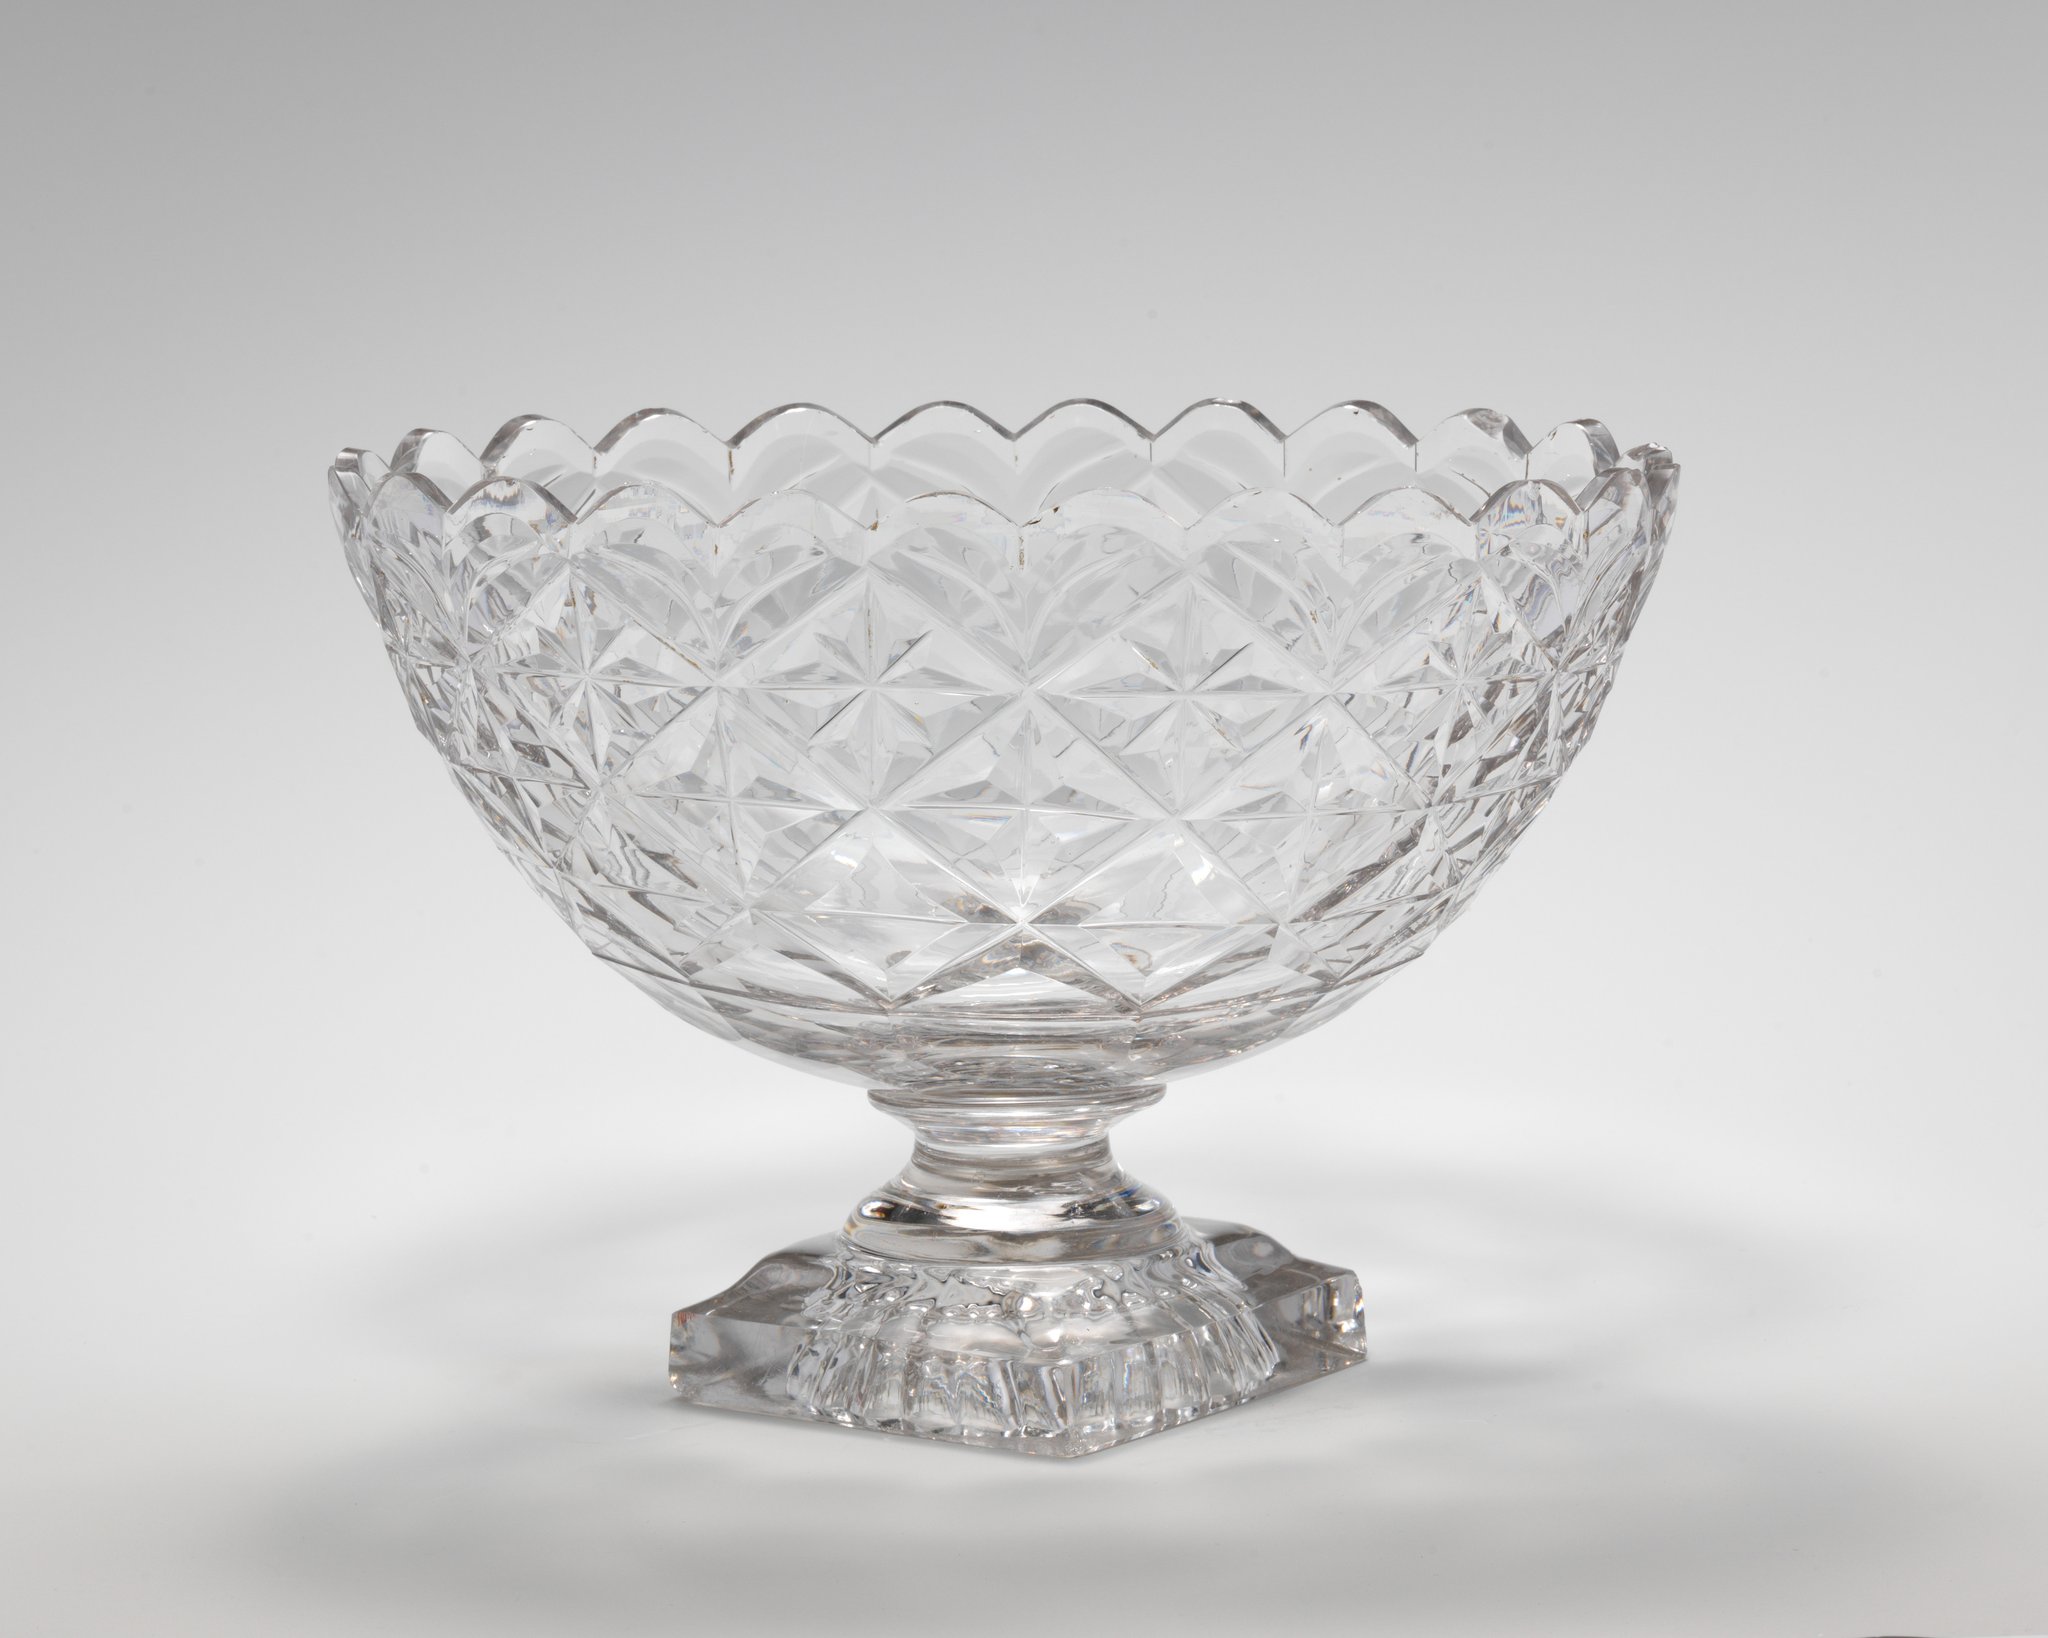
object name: salad or fruit bowl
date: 1701-1900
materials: glass